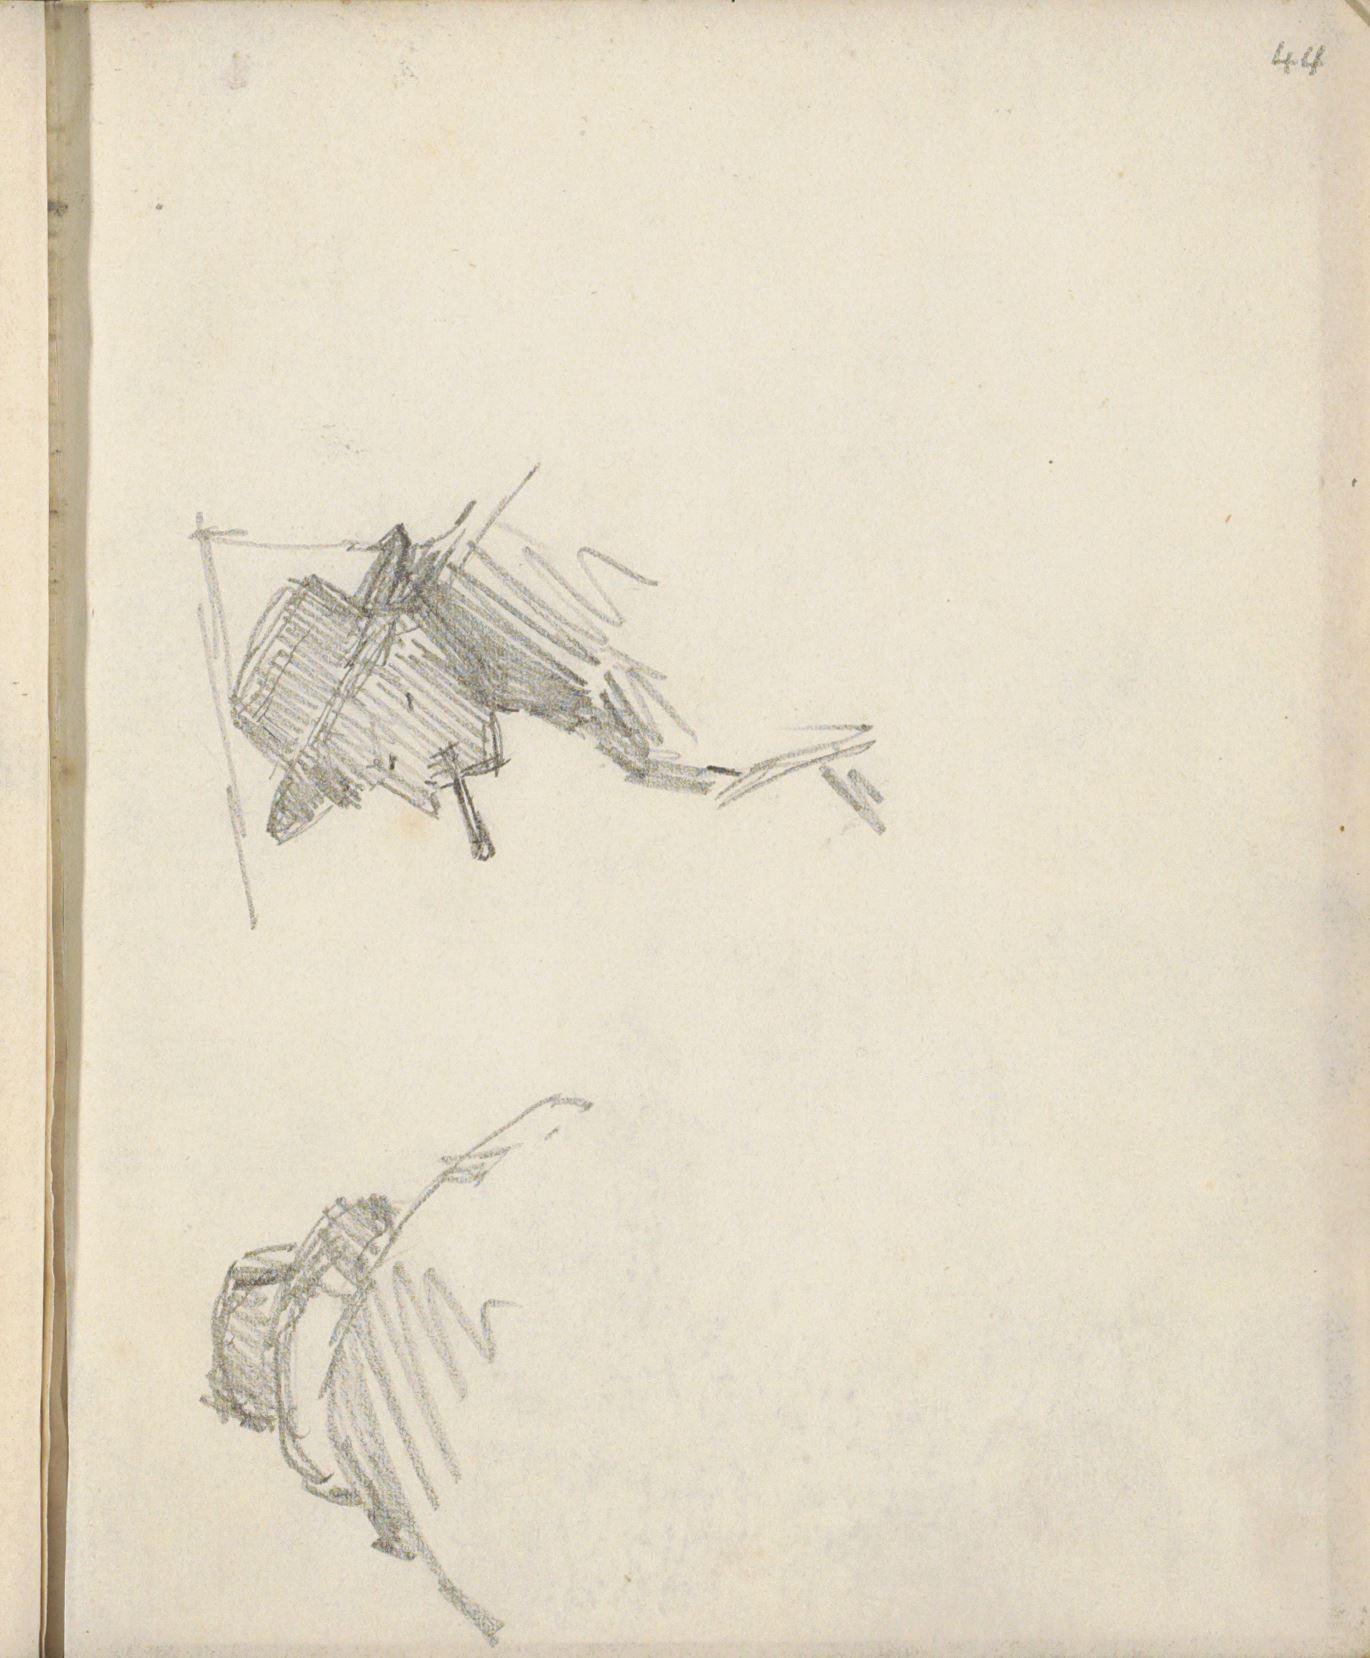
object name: sketchbook leaf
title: Man met een hoed en sigaar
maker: alfred william rich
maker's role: draughtsman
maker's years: 1856-1921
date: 1892-1893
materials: paper, pencil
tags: cigar, head-gear: hat (+ men's clothes)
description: Blad 44 recto uit een schetsboek met 86 bladen.